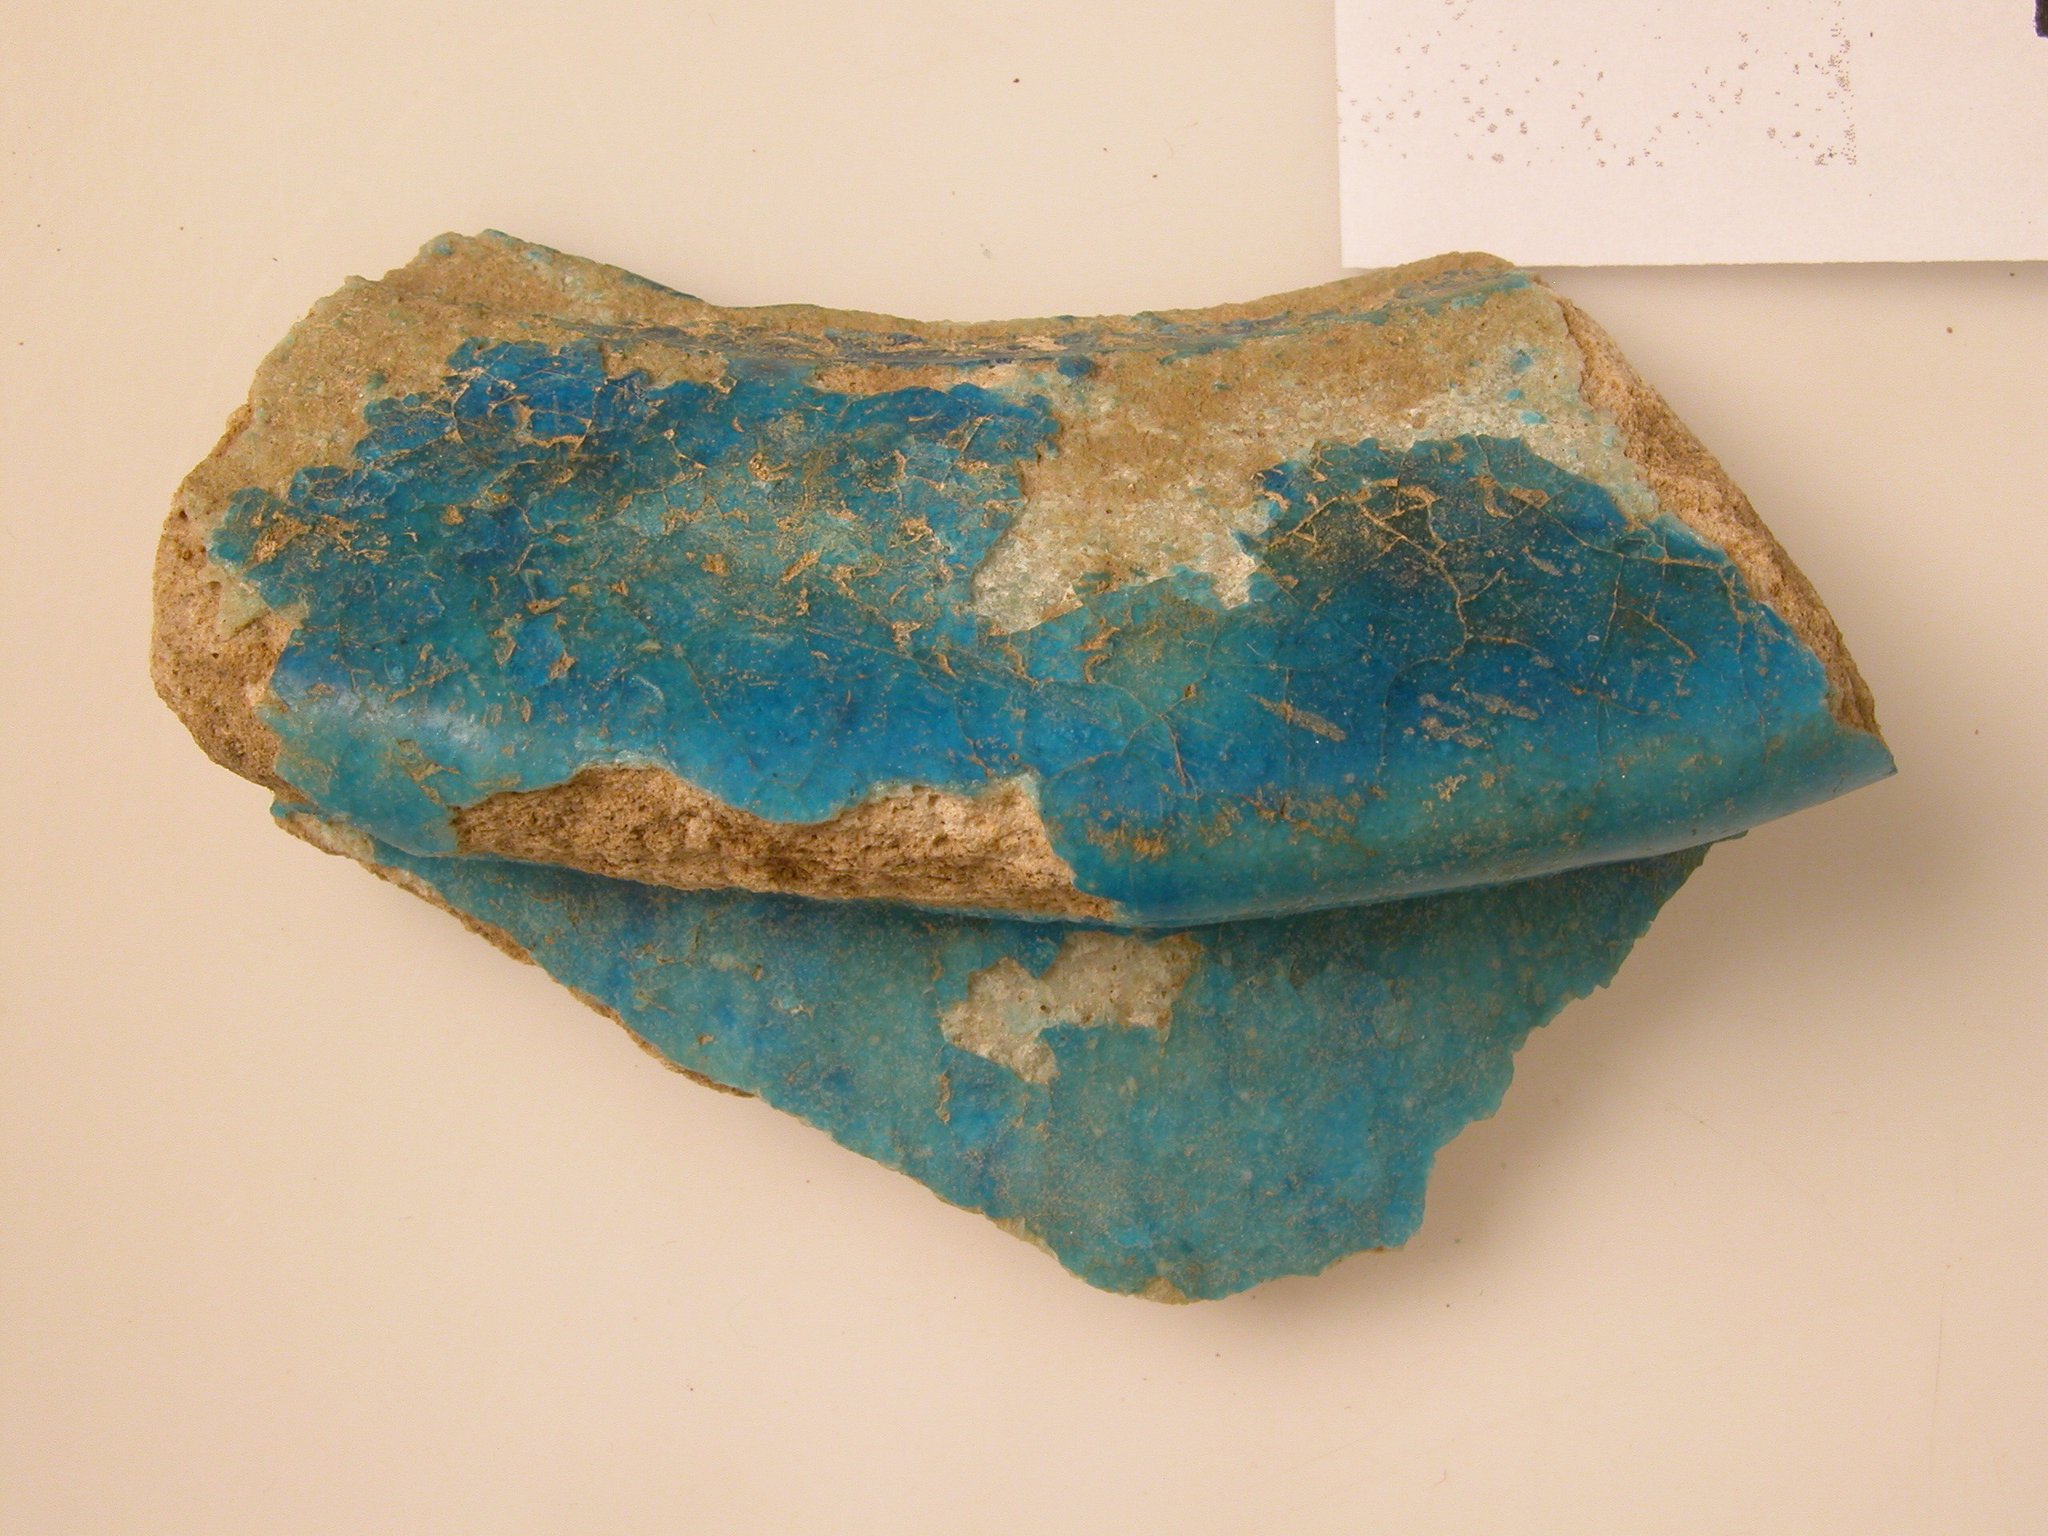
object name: fragment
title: Pottery Fragment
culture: coptic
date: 301-700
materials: earthenware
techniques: glazing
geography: egypt